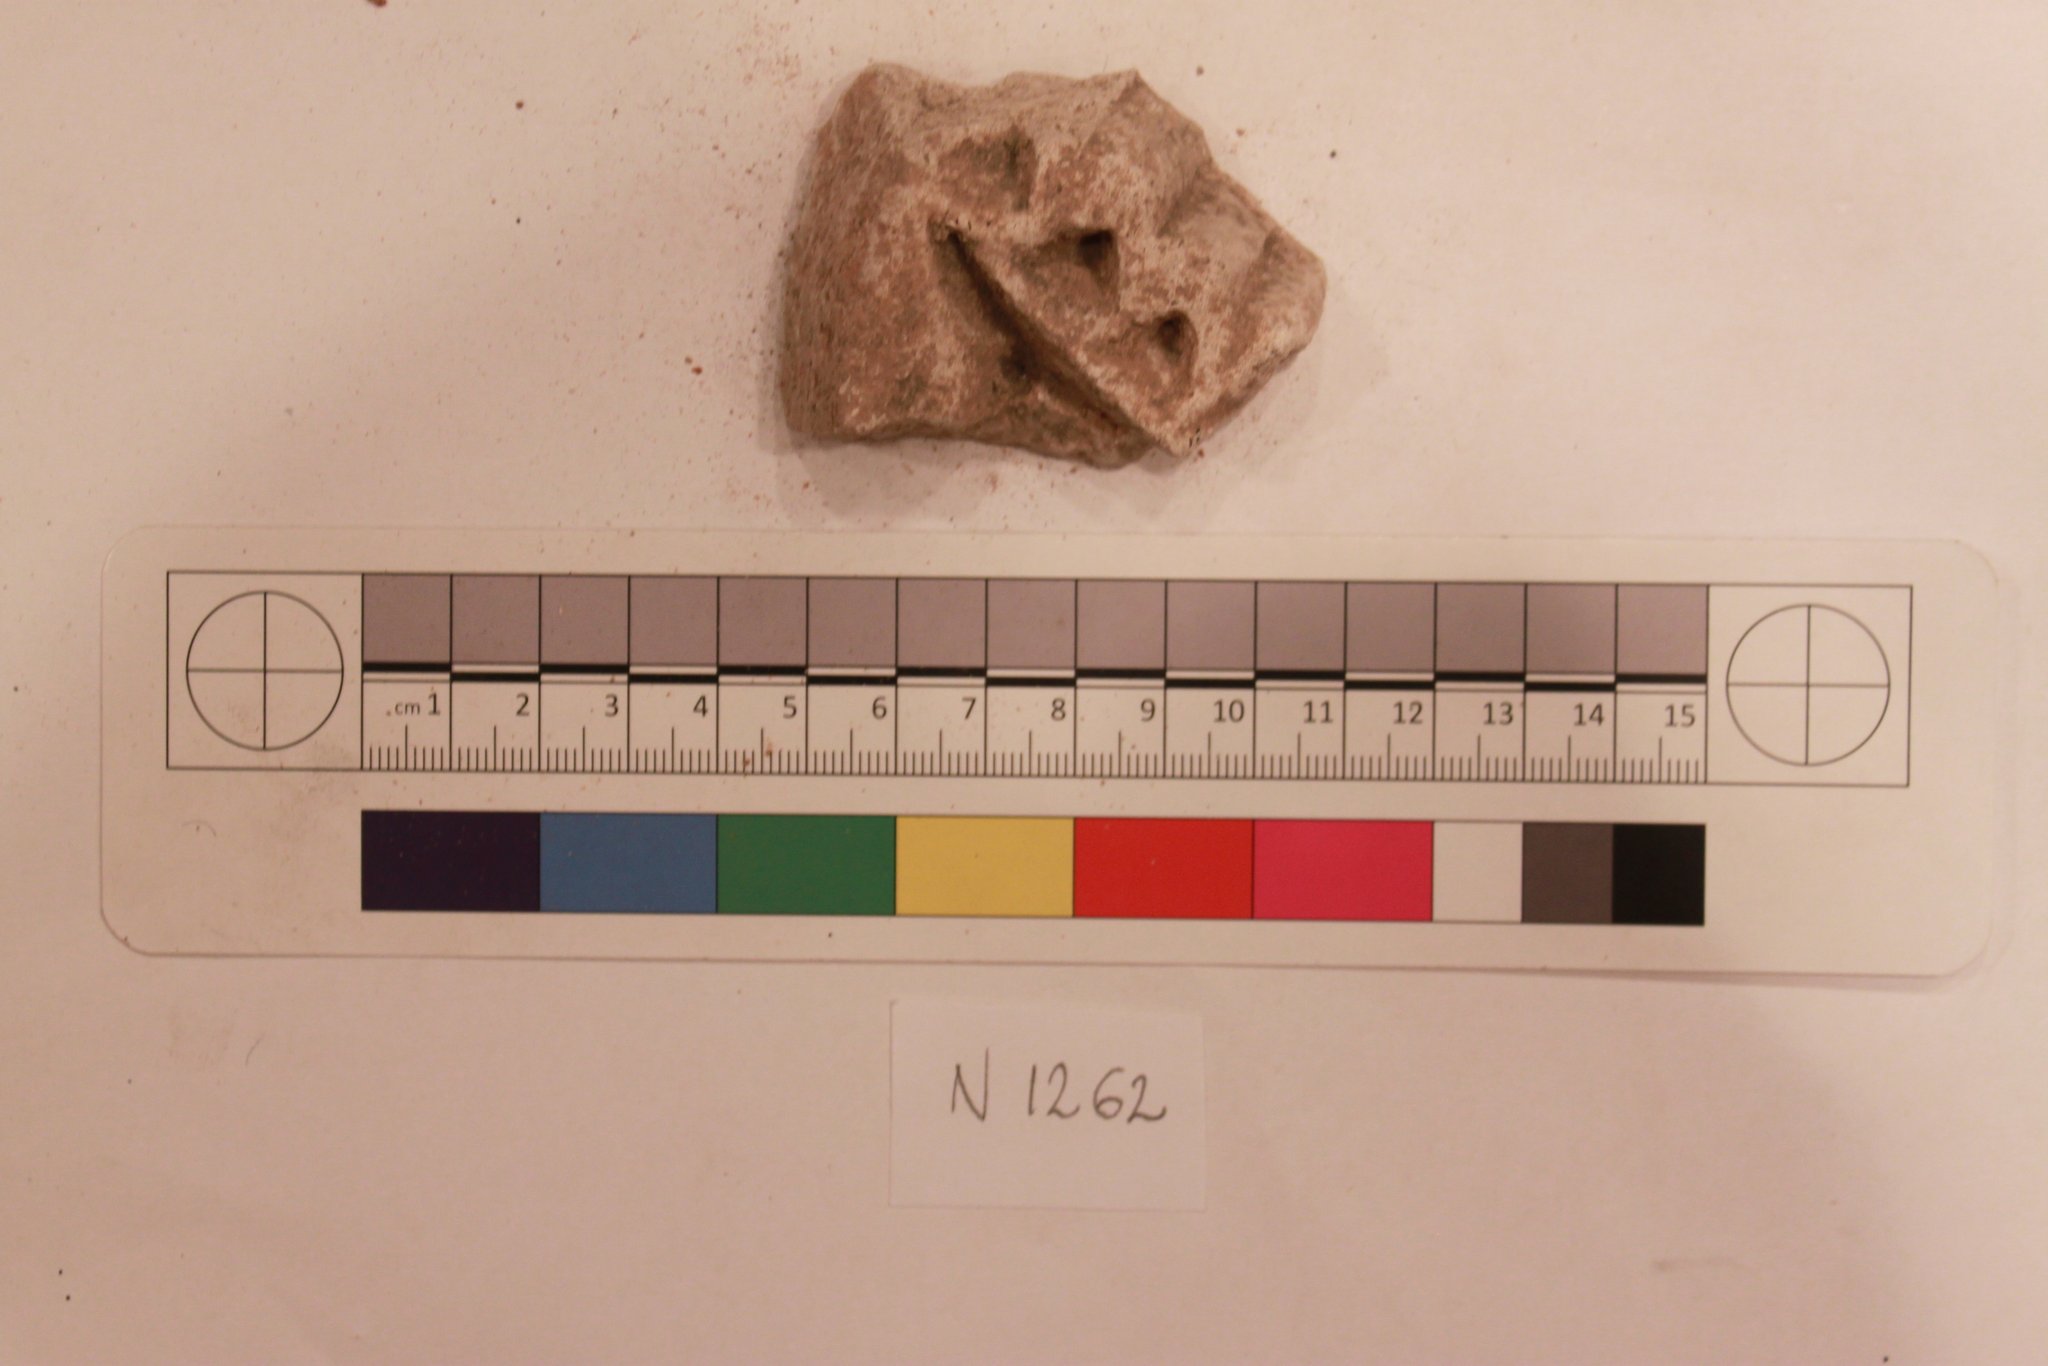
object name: fragment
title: Stucco Fragment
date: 701-1200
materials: plaster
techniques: carving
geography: iran